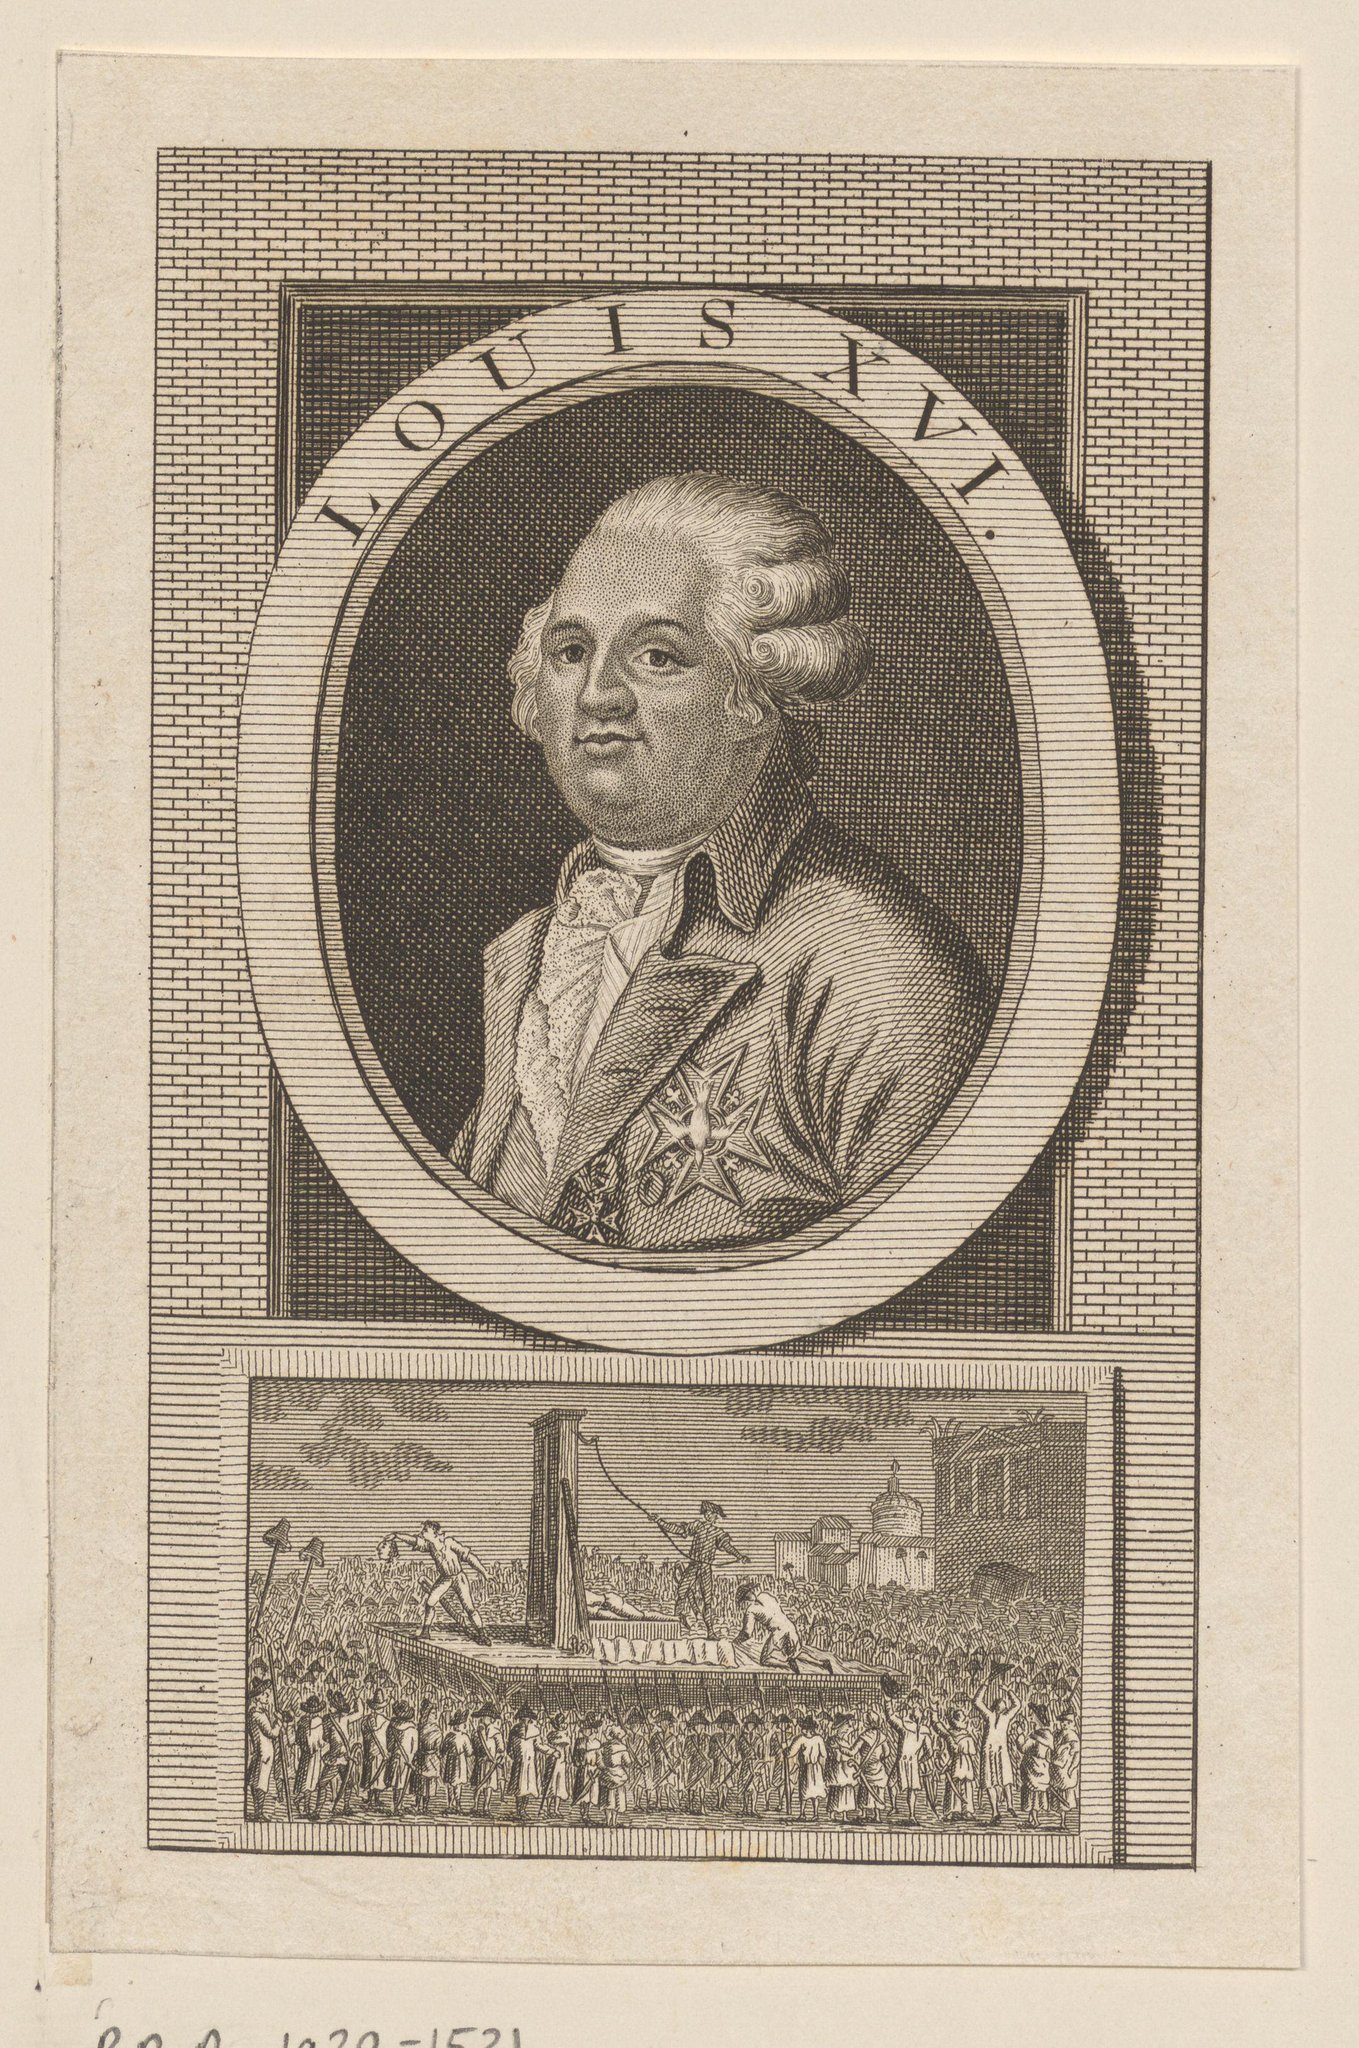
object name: print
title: Portret van Lodewijk XVI van Frankrijk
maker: Anonymous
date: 1793-1799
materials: paper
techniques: engraving, etching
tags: lodewijk xvi (koning van frankrijk), violent death ~ beheading by guillotine, ornament ~ medallion, historical persons, death penalty, execution, king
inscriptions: collector's mark: Lugt 2228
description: Onder het portret de onthoofding van Lodewijk XVI.